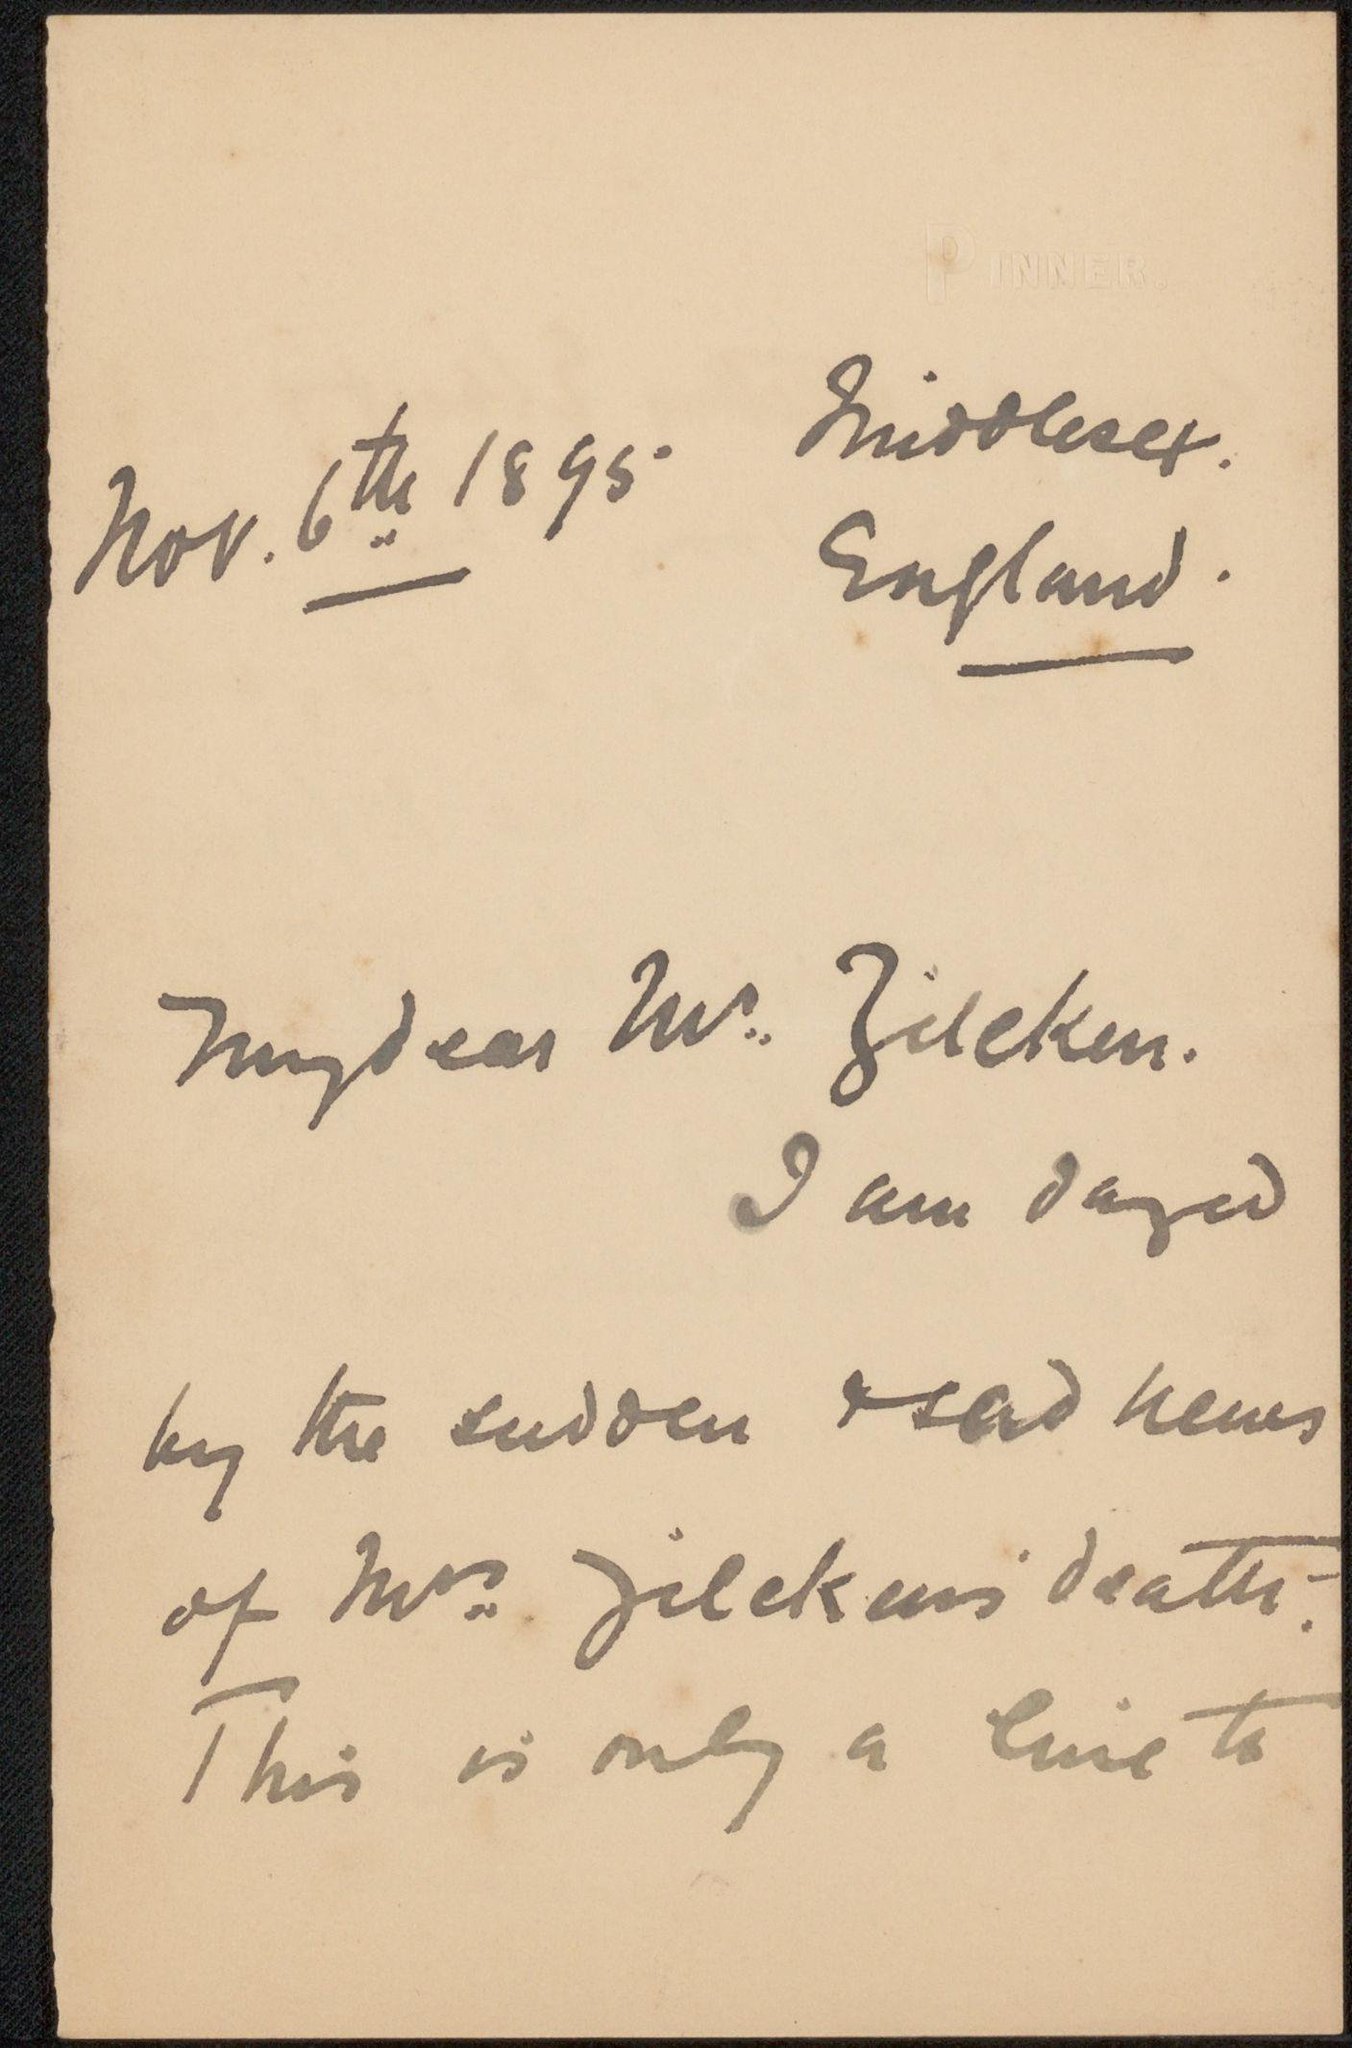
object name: letter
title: Brief aan Philip Zilcken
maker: Anonymous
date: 1895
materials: ink, paper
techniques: pen, writing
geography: middlesex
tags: elbert jan van wisselingh, brussels, helène lambertine hauzeur, the hague, painter, draughtsman, philip zilcken, passions, emotions, affections, diseases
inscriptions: watermark